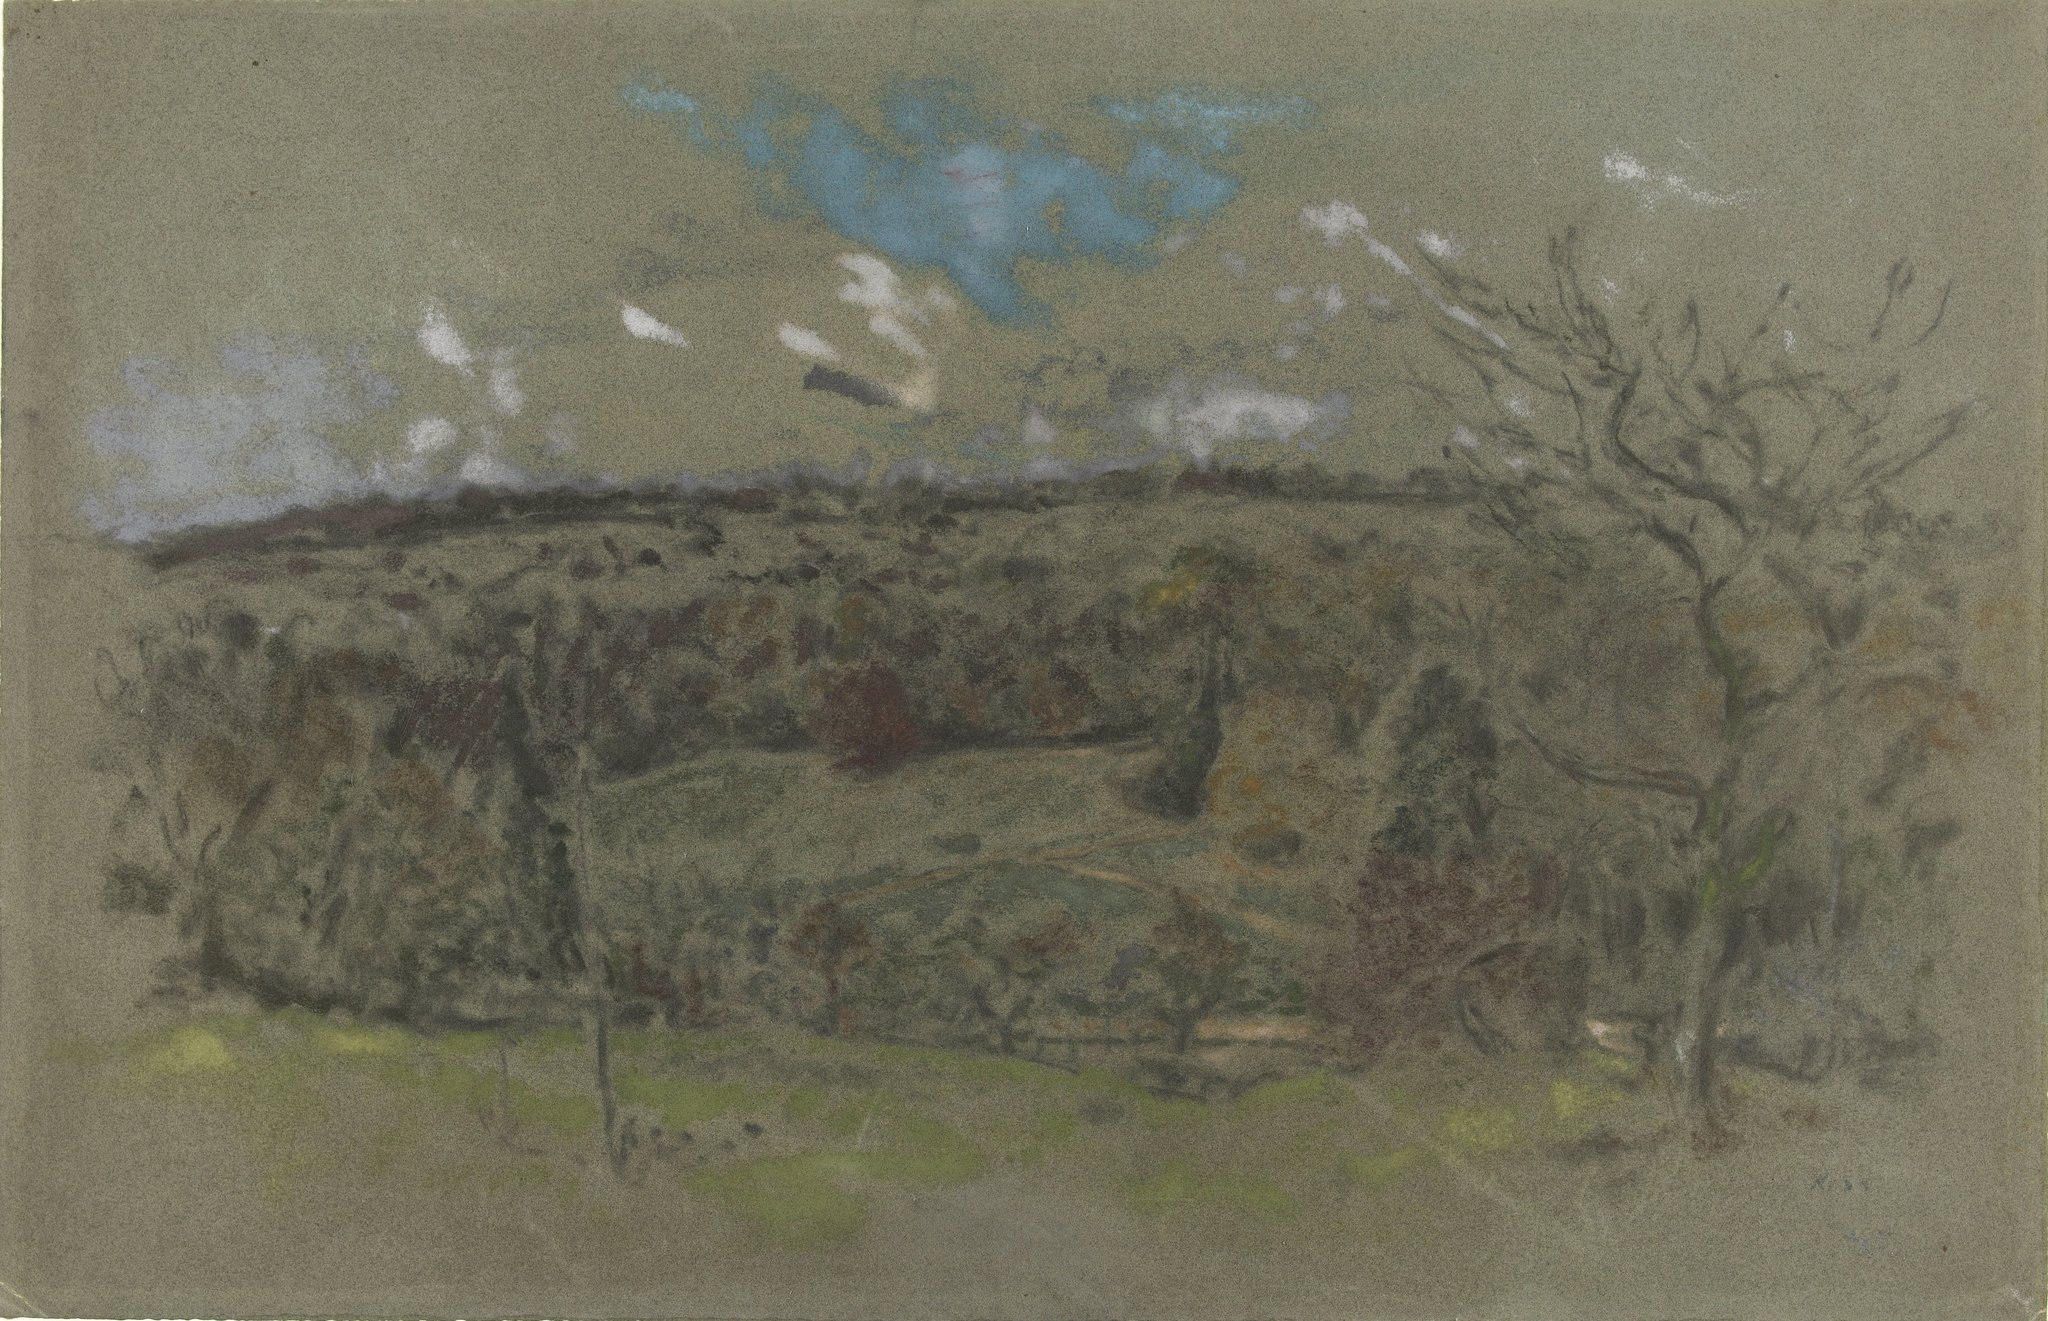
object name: drawing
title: Heuvelachtig landschap in herfstkleuren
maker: ker xavier roussel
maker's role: draughtsman, print maker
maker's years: 1867-1944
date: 1877-1944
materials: chalk, paper, pastel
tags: low hill country